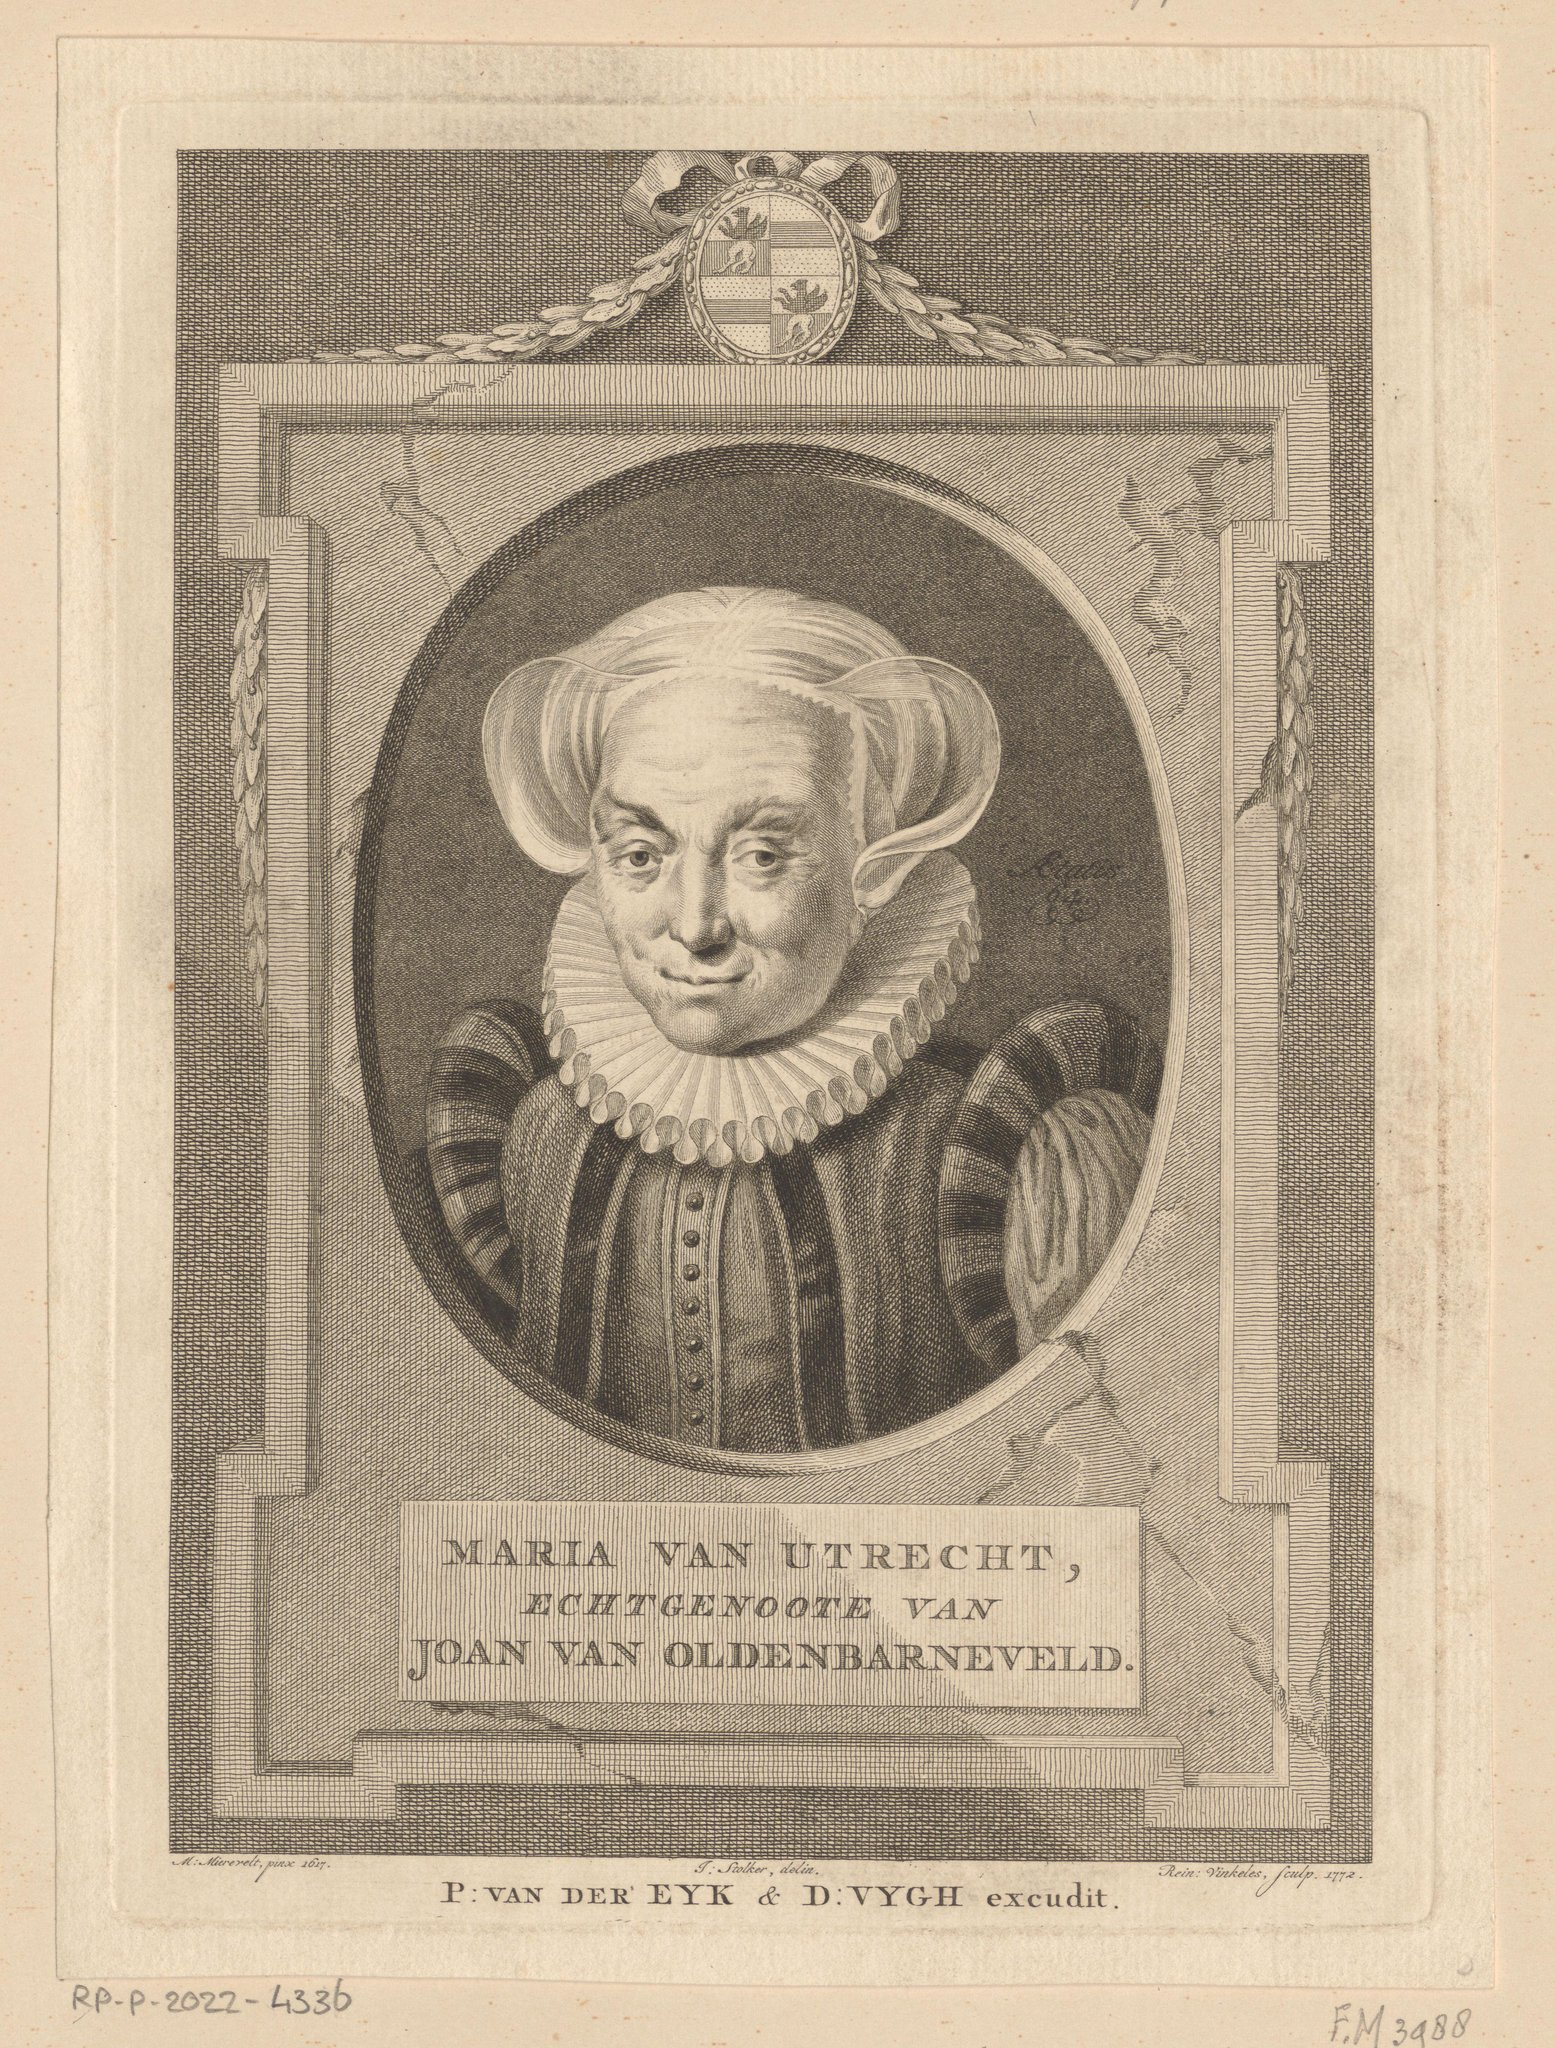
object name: print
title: Portret van Maria van Utrecht op 64-jarige leeftijd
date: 1772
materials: paper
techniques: engraving, etching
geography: leiden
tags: historical persons - bb - woman